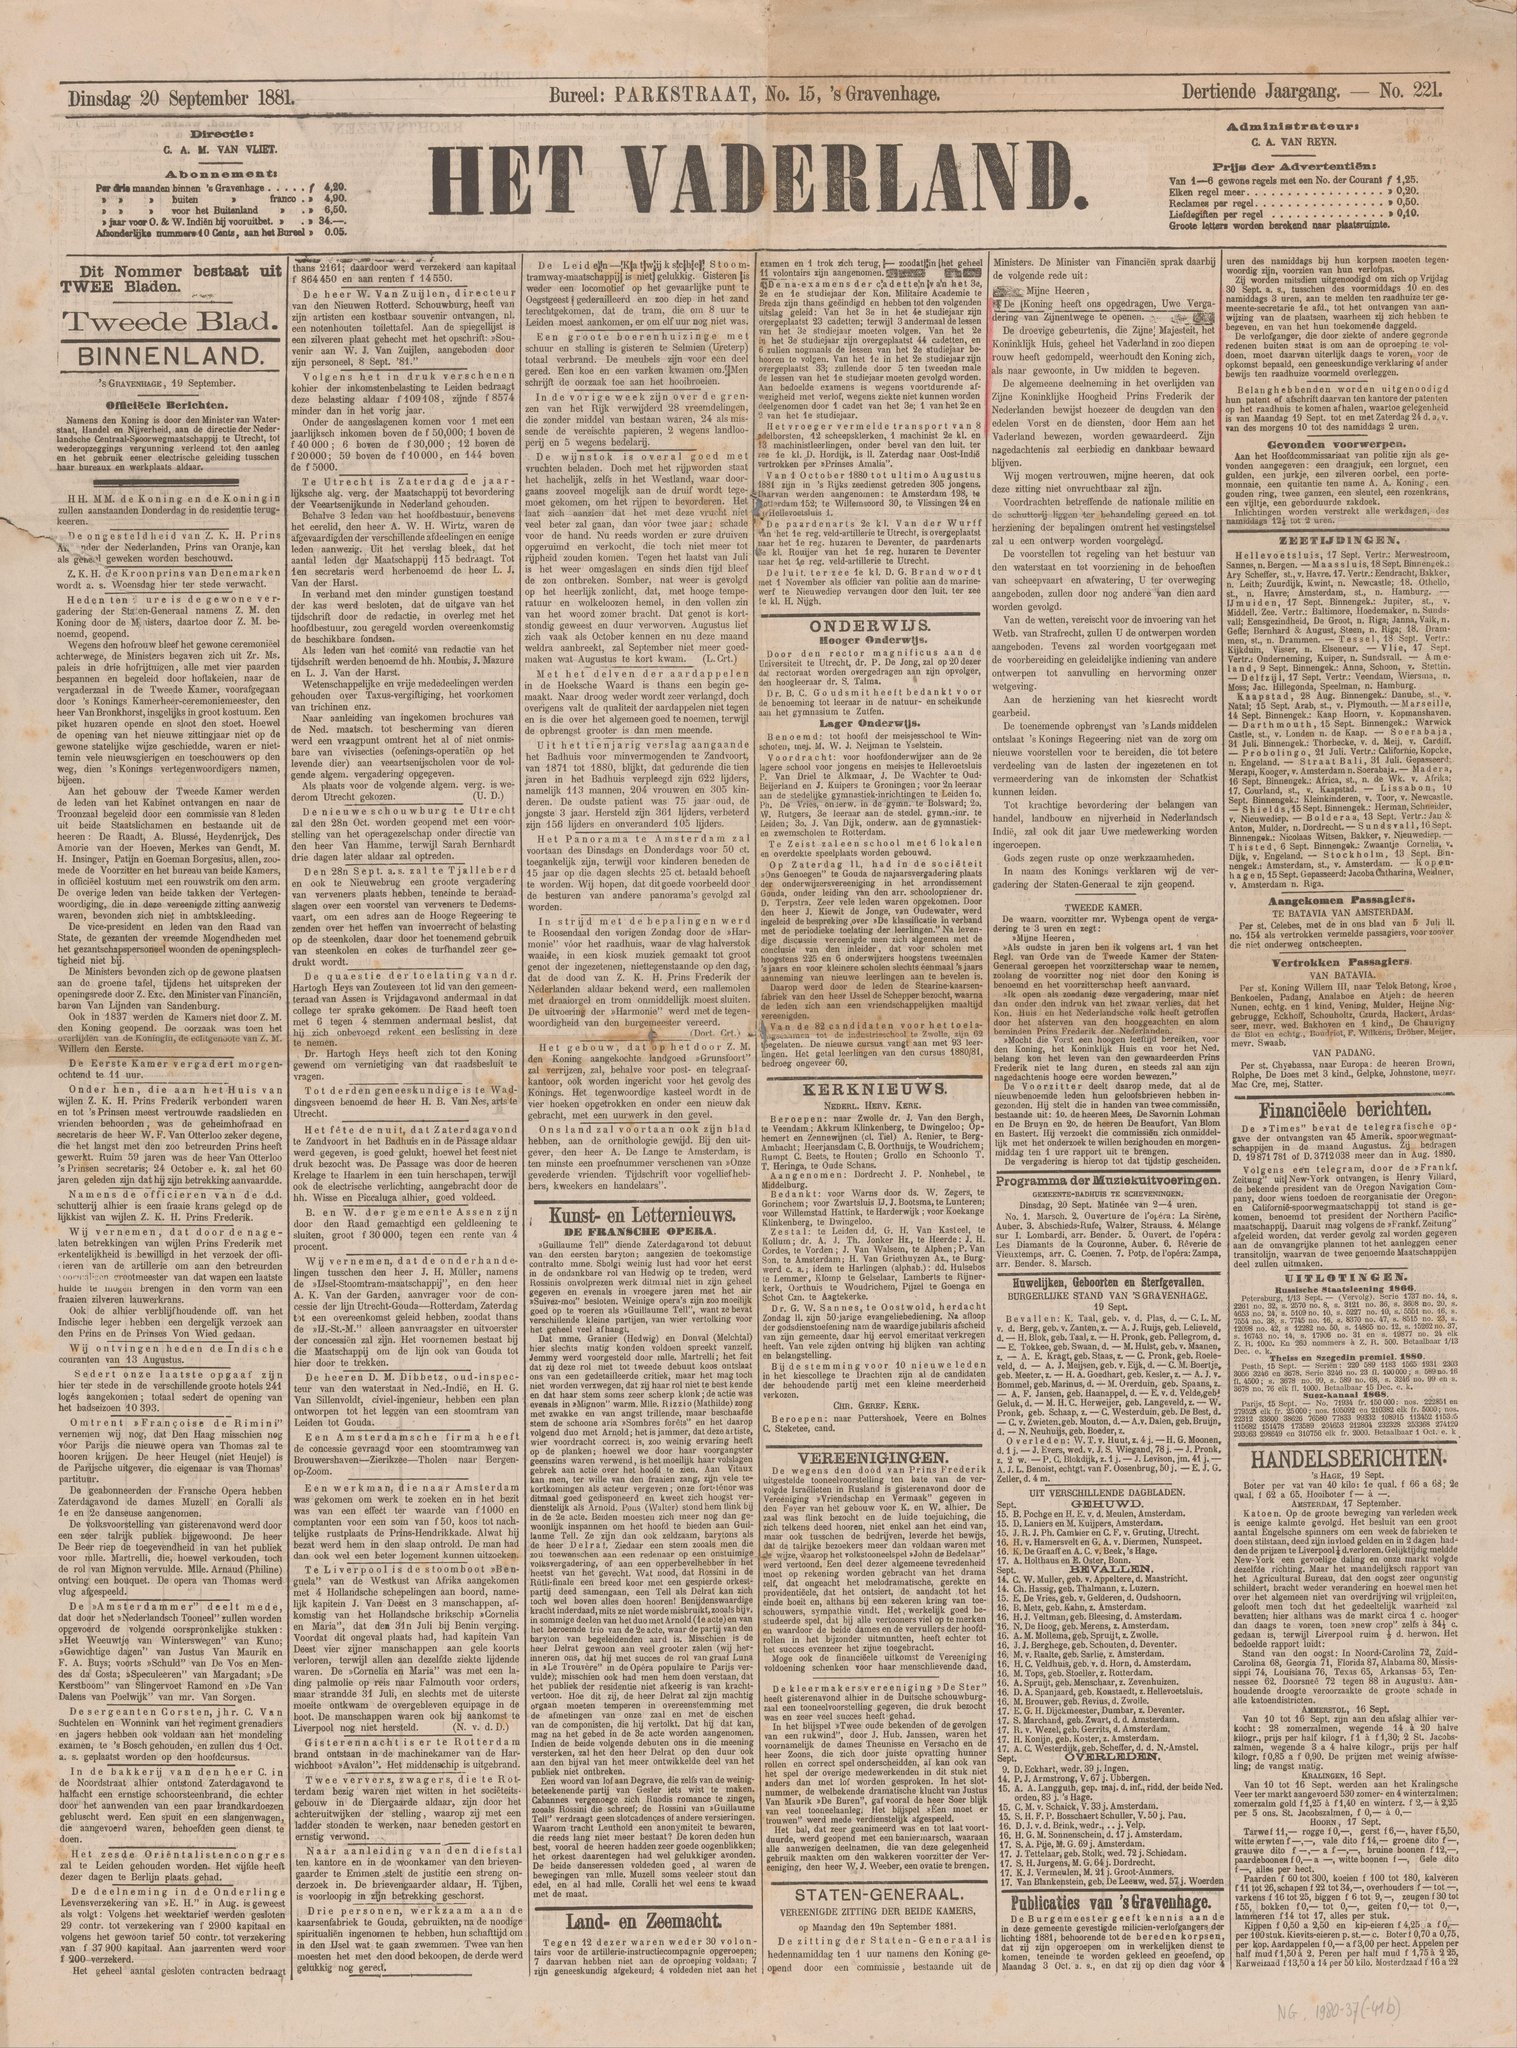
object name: newspaper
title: Het Vaderland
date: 1881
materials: paper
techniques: printing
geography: the hague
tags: berlin, frederik (prins der nederlanden), netherlands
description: Krant nr. 221 van de 13e jaargang van "Het Vaderland", 2 pp met berichten over de dood van prins Frederik.